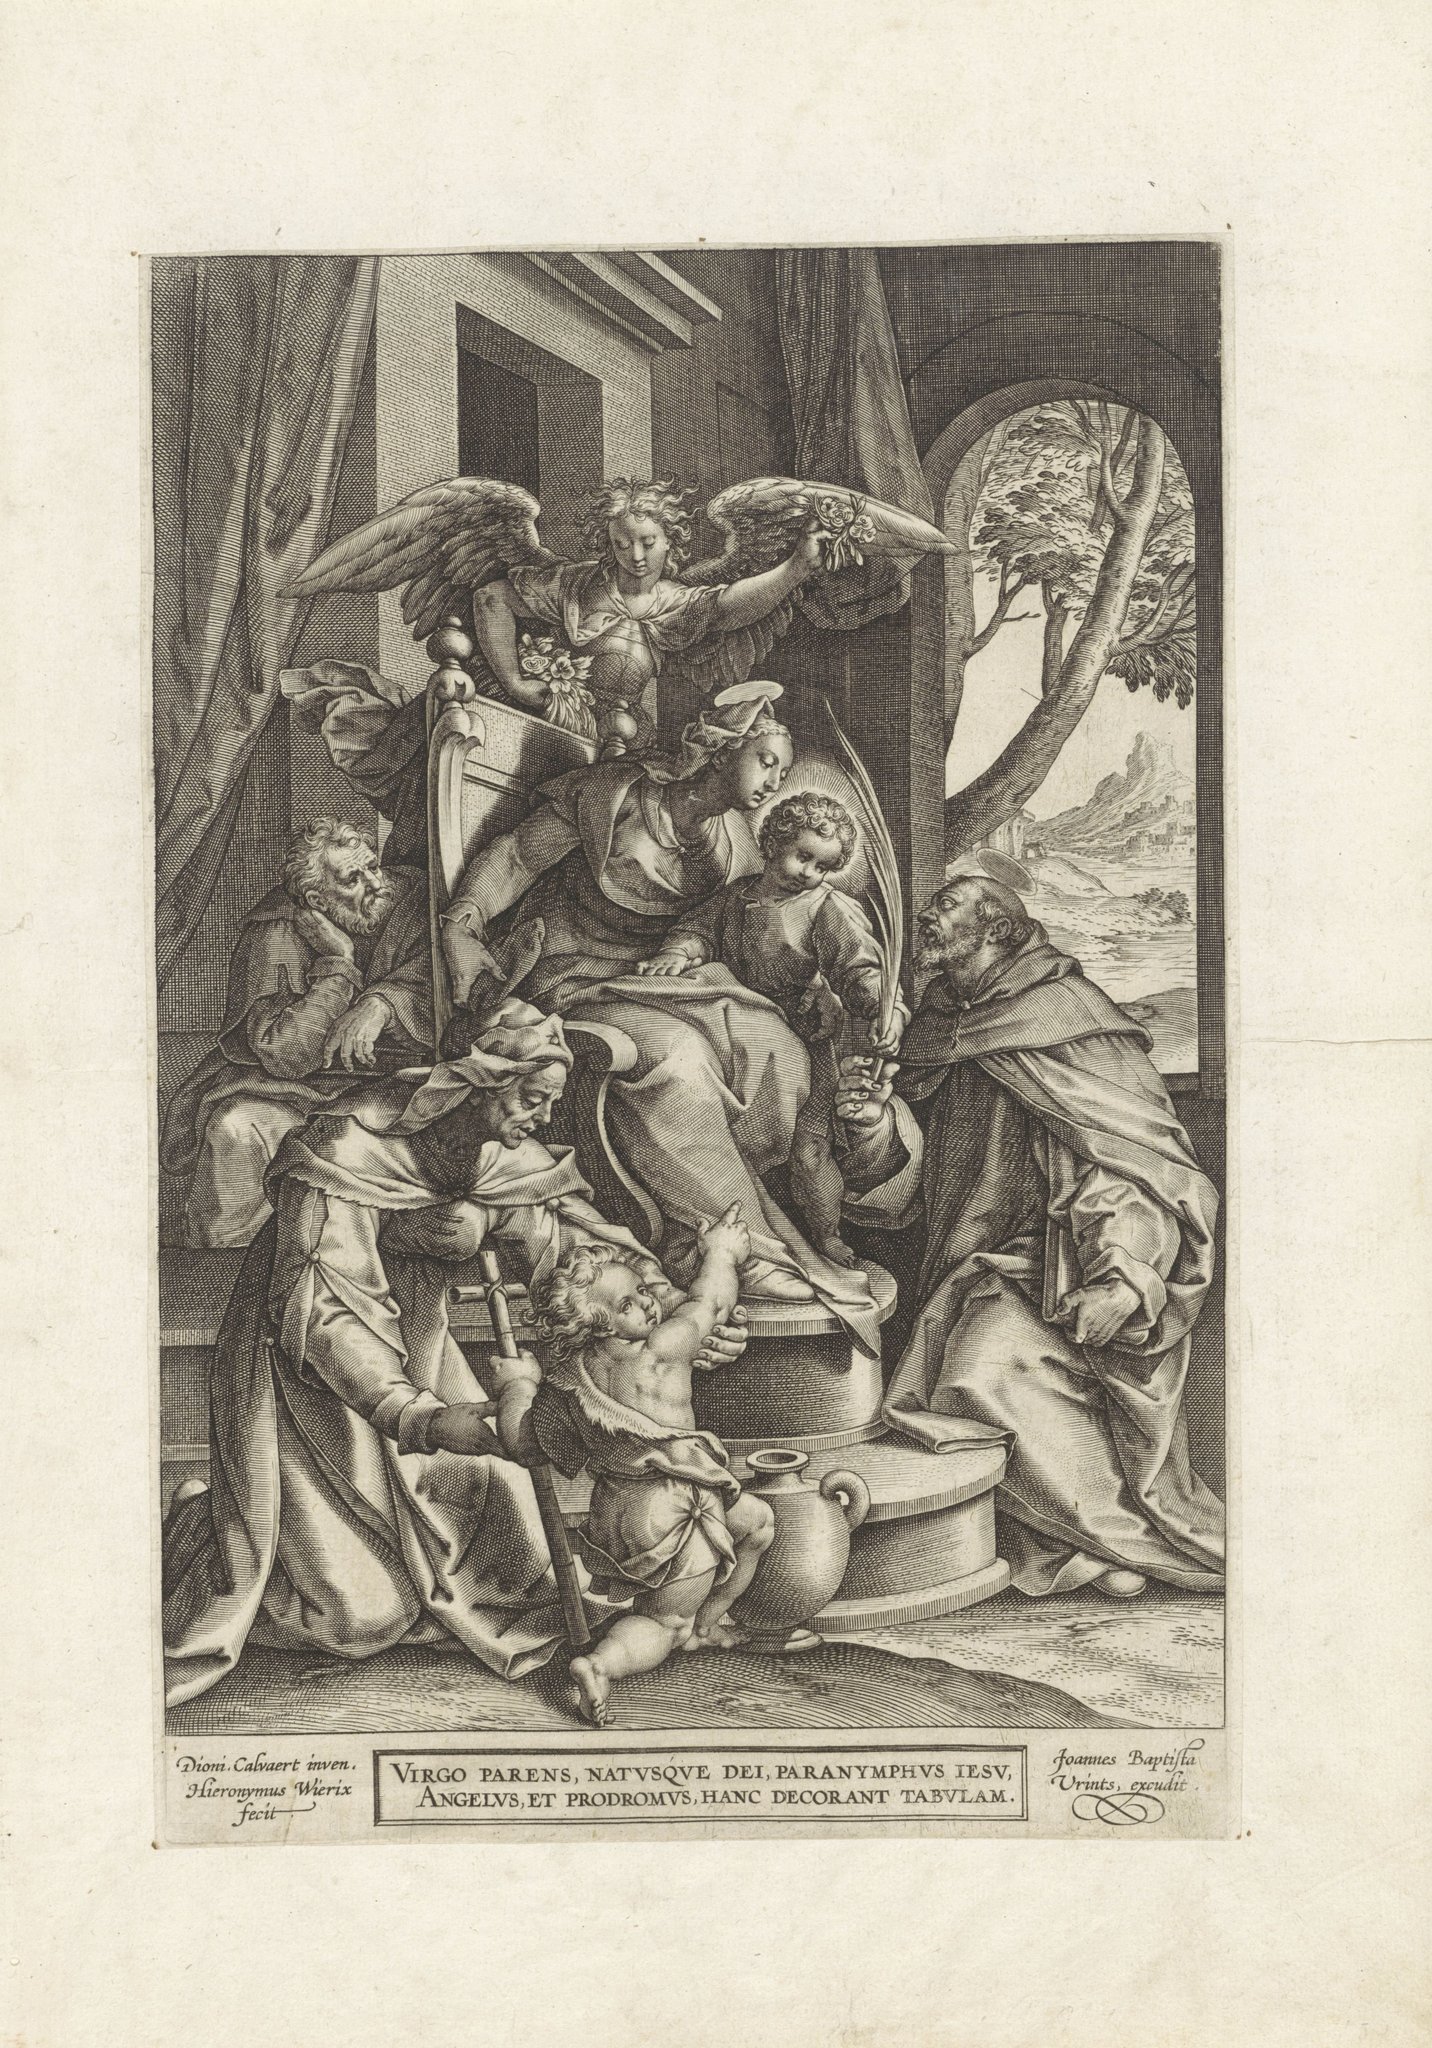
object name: print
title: Heilige Familie met Elisabet en Johannes de Doper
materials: paper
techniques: engraving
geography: antwerp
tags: holy family with john the baptist, elisabeth present (+ angel(s)), martyr(s) (often with palm-branches)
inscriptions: collector's mark: Lugt 2760, collector's mark: Lugt 2228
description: Maria zit op een troon met het Christuskind op haar schoot. Het Kind overhandigt een palmtak aan een heilige. Achter de troon kijkt Jozef vanaf een afstand toe. Een engel leunt op de rugleuning van de troon en houdt bloemen boven Maria. Elisabet en de jonge Johannes de Doper zitten geknield op de voorgrond. Johannes wijst naar het Christuskind. In het kader in de marge een tweeregelig onderschrift in het Latijn.